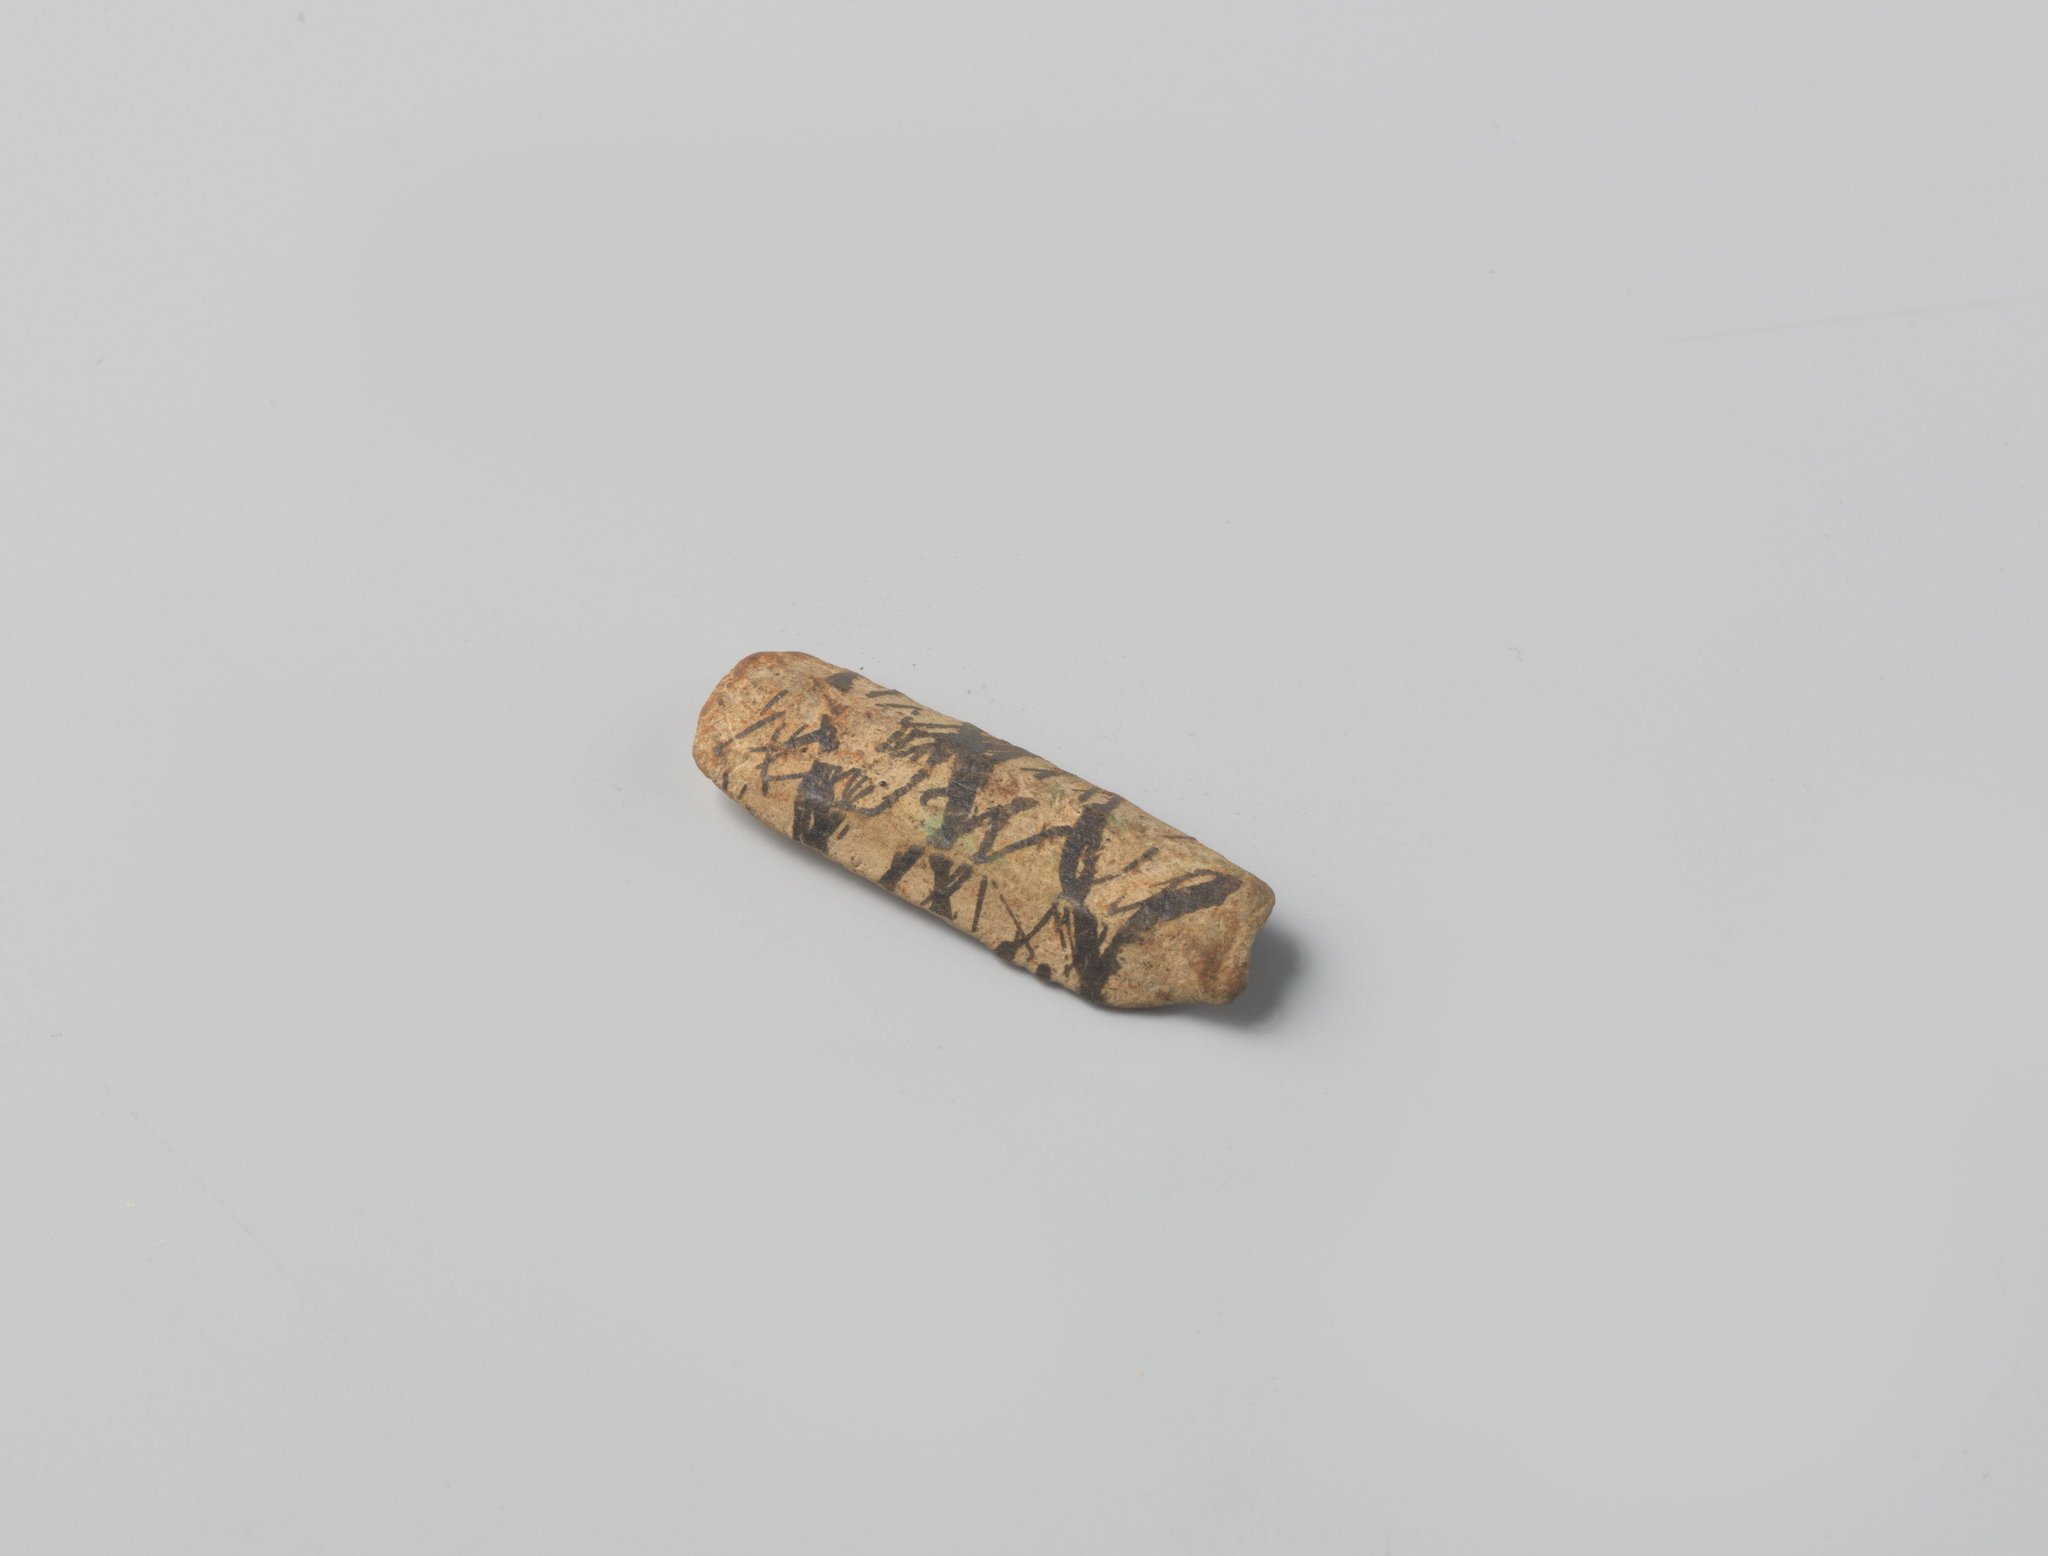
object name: knife handle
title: Half messenheft uit het wrak van de Oostindiëvaarder Hollandia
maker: Anonymous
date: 1700-1743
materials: bone, ink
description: Half messenheft met versiering van inkt of verf.